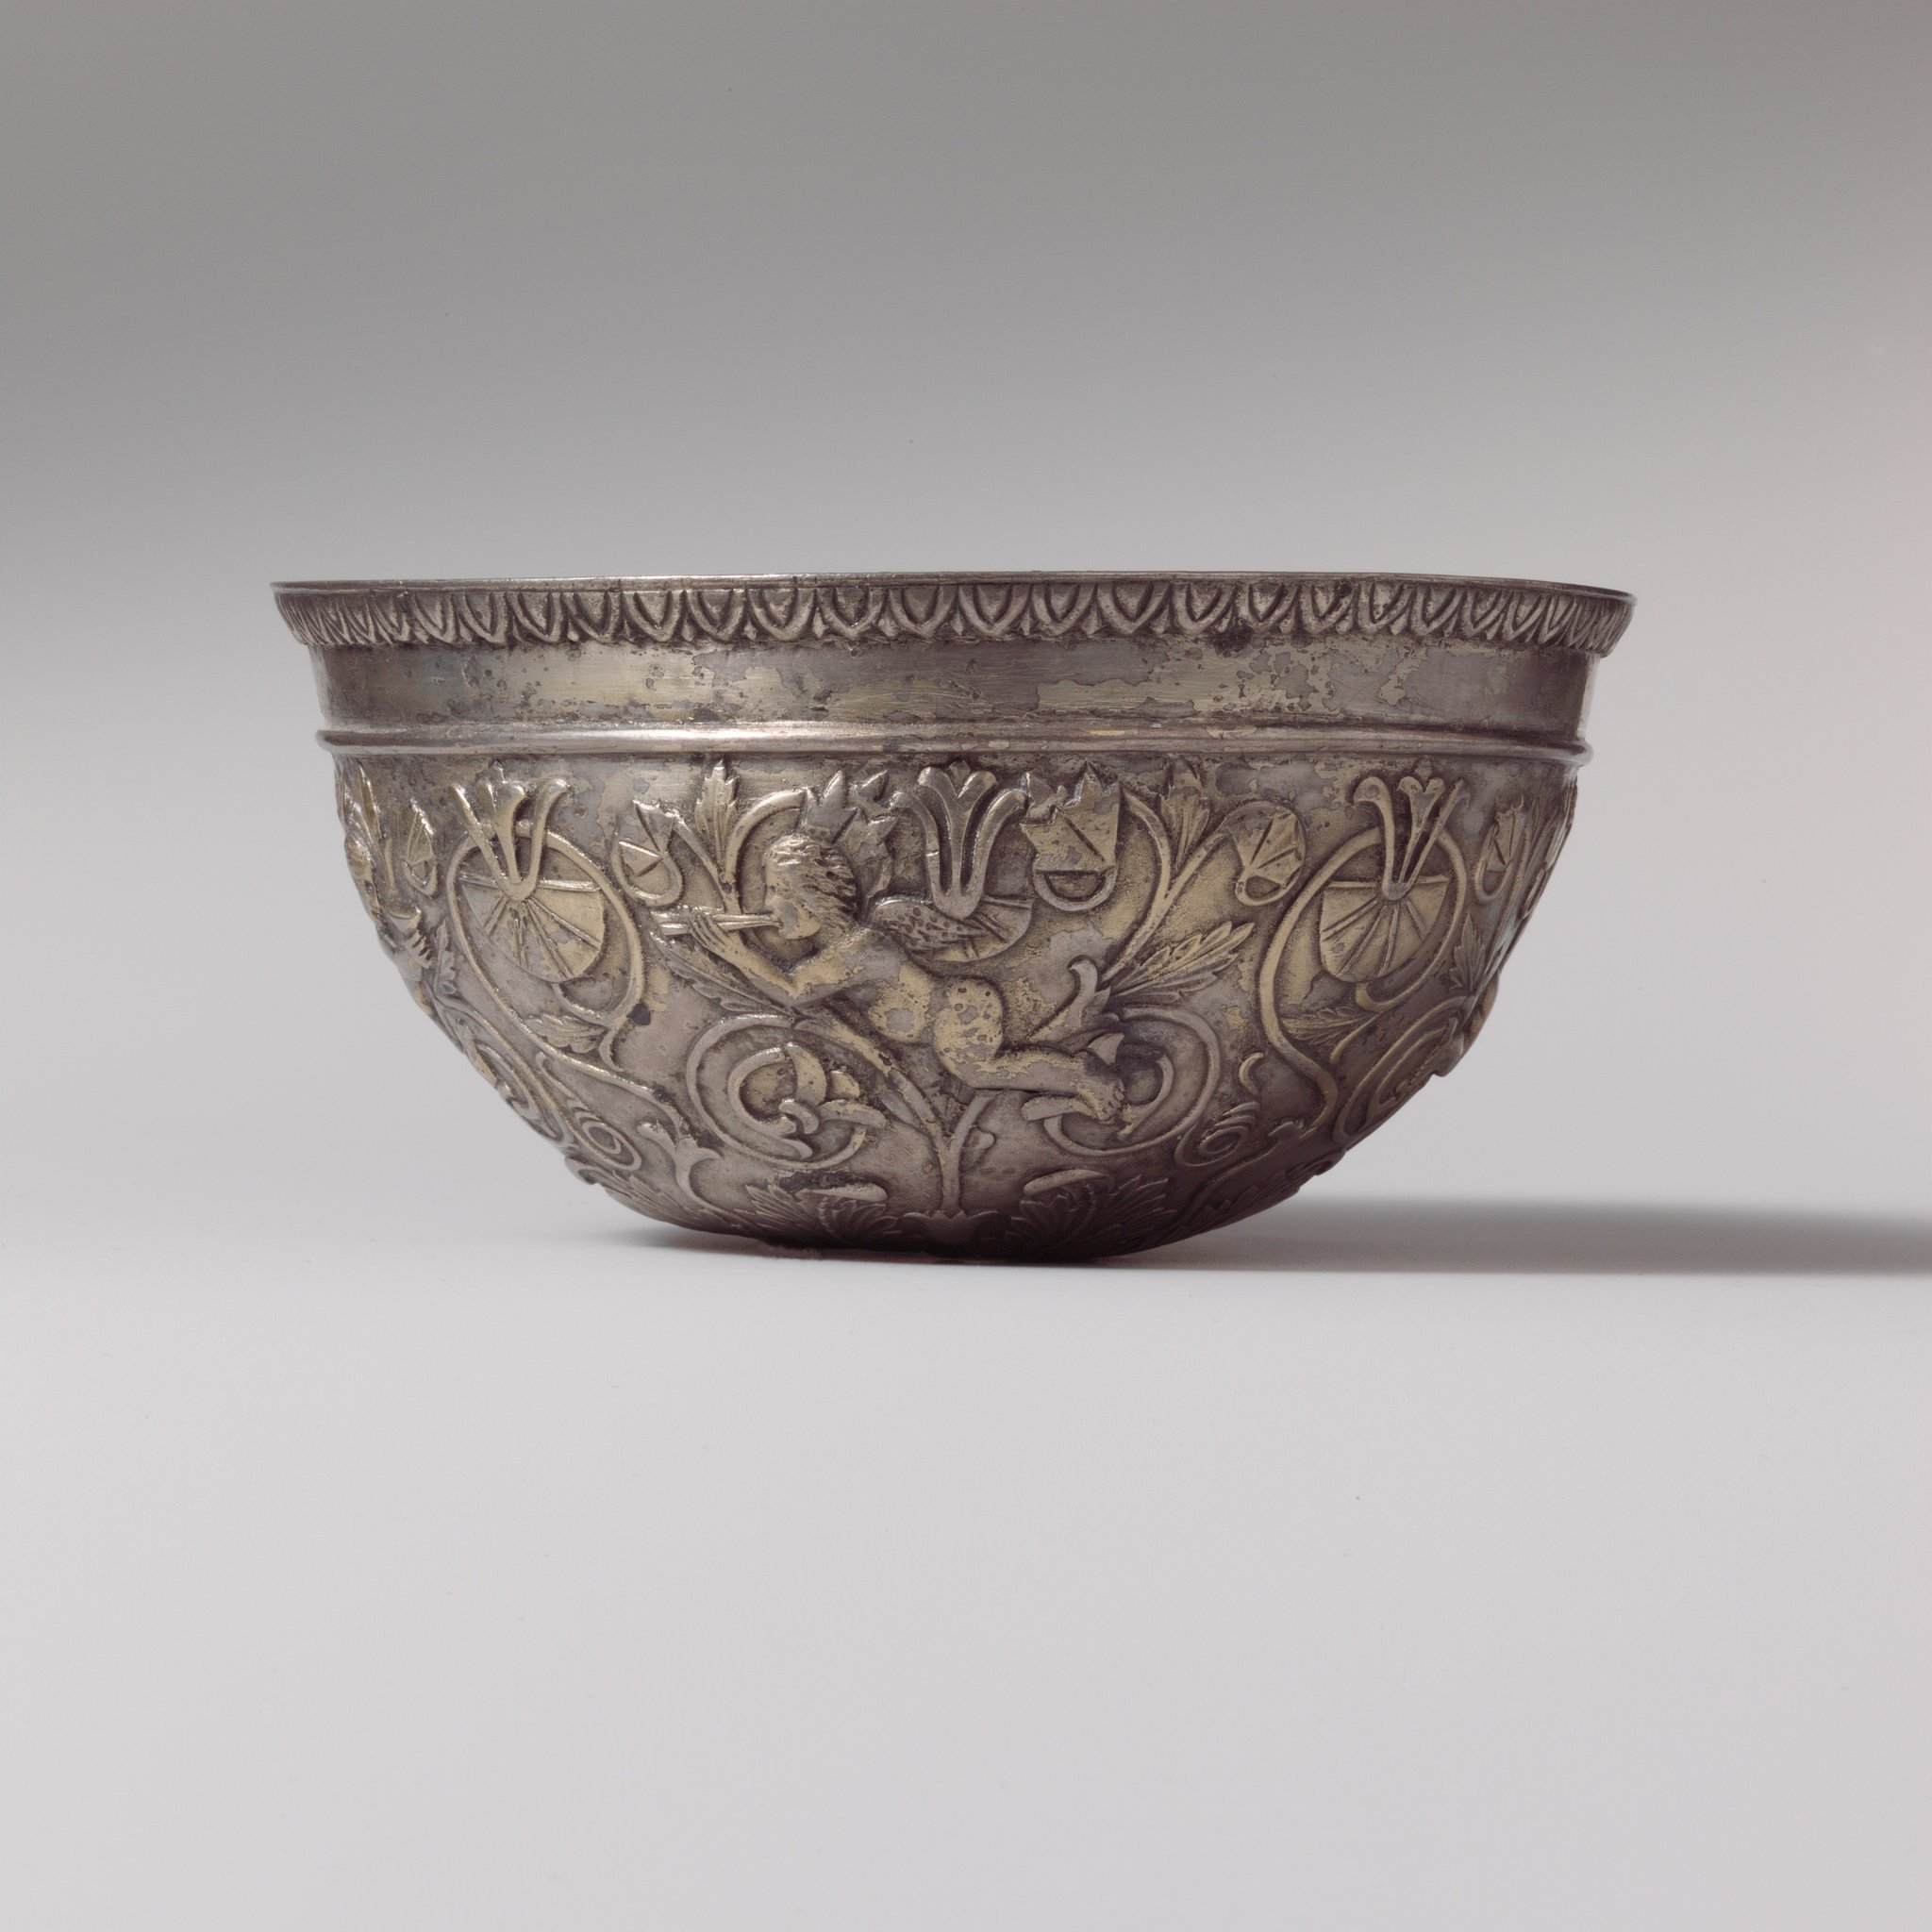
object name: bowl with gilding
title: Silver-gilt bowl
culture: greek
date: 200-1 BCE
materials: silver gilt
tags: flutes,eros